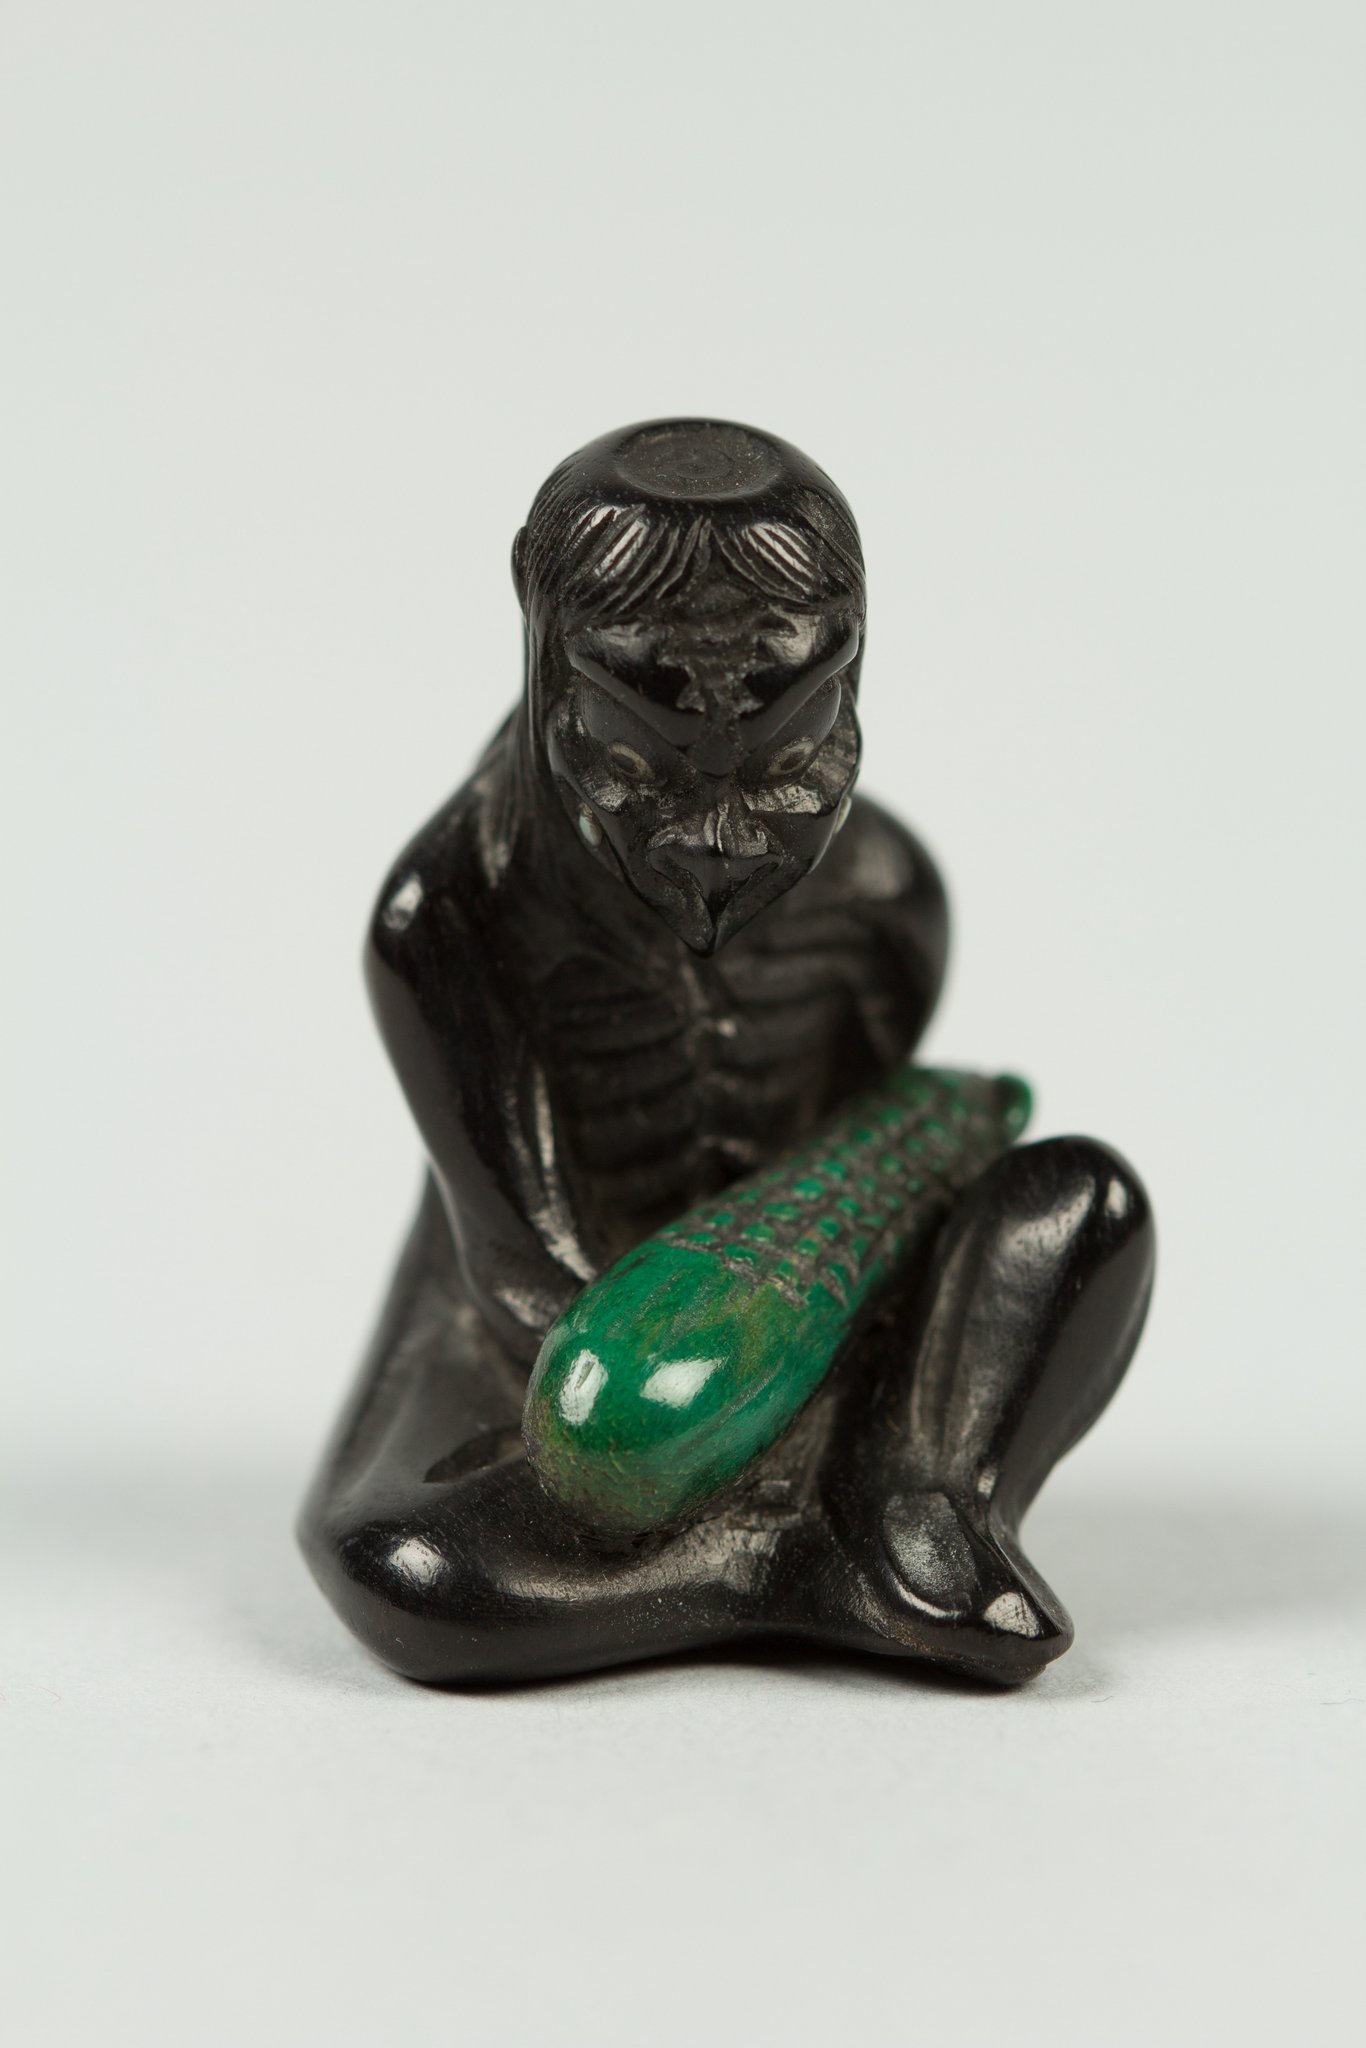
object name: netsuke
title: Kappa with a cucumber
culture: japanese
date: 1801-1900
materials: wood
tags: vegetables,demons